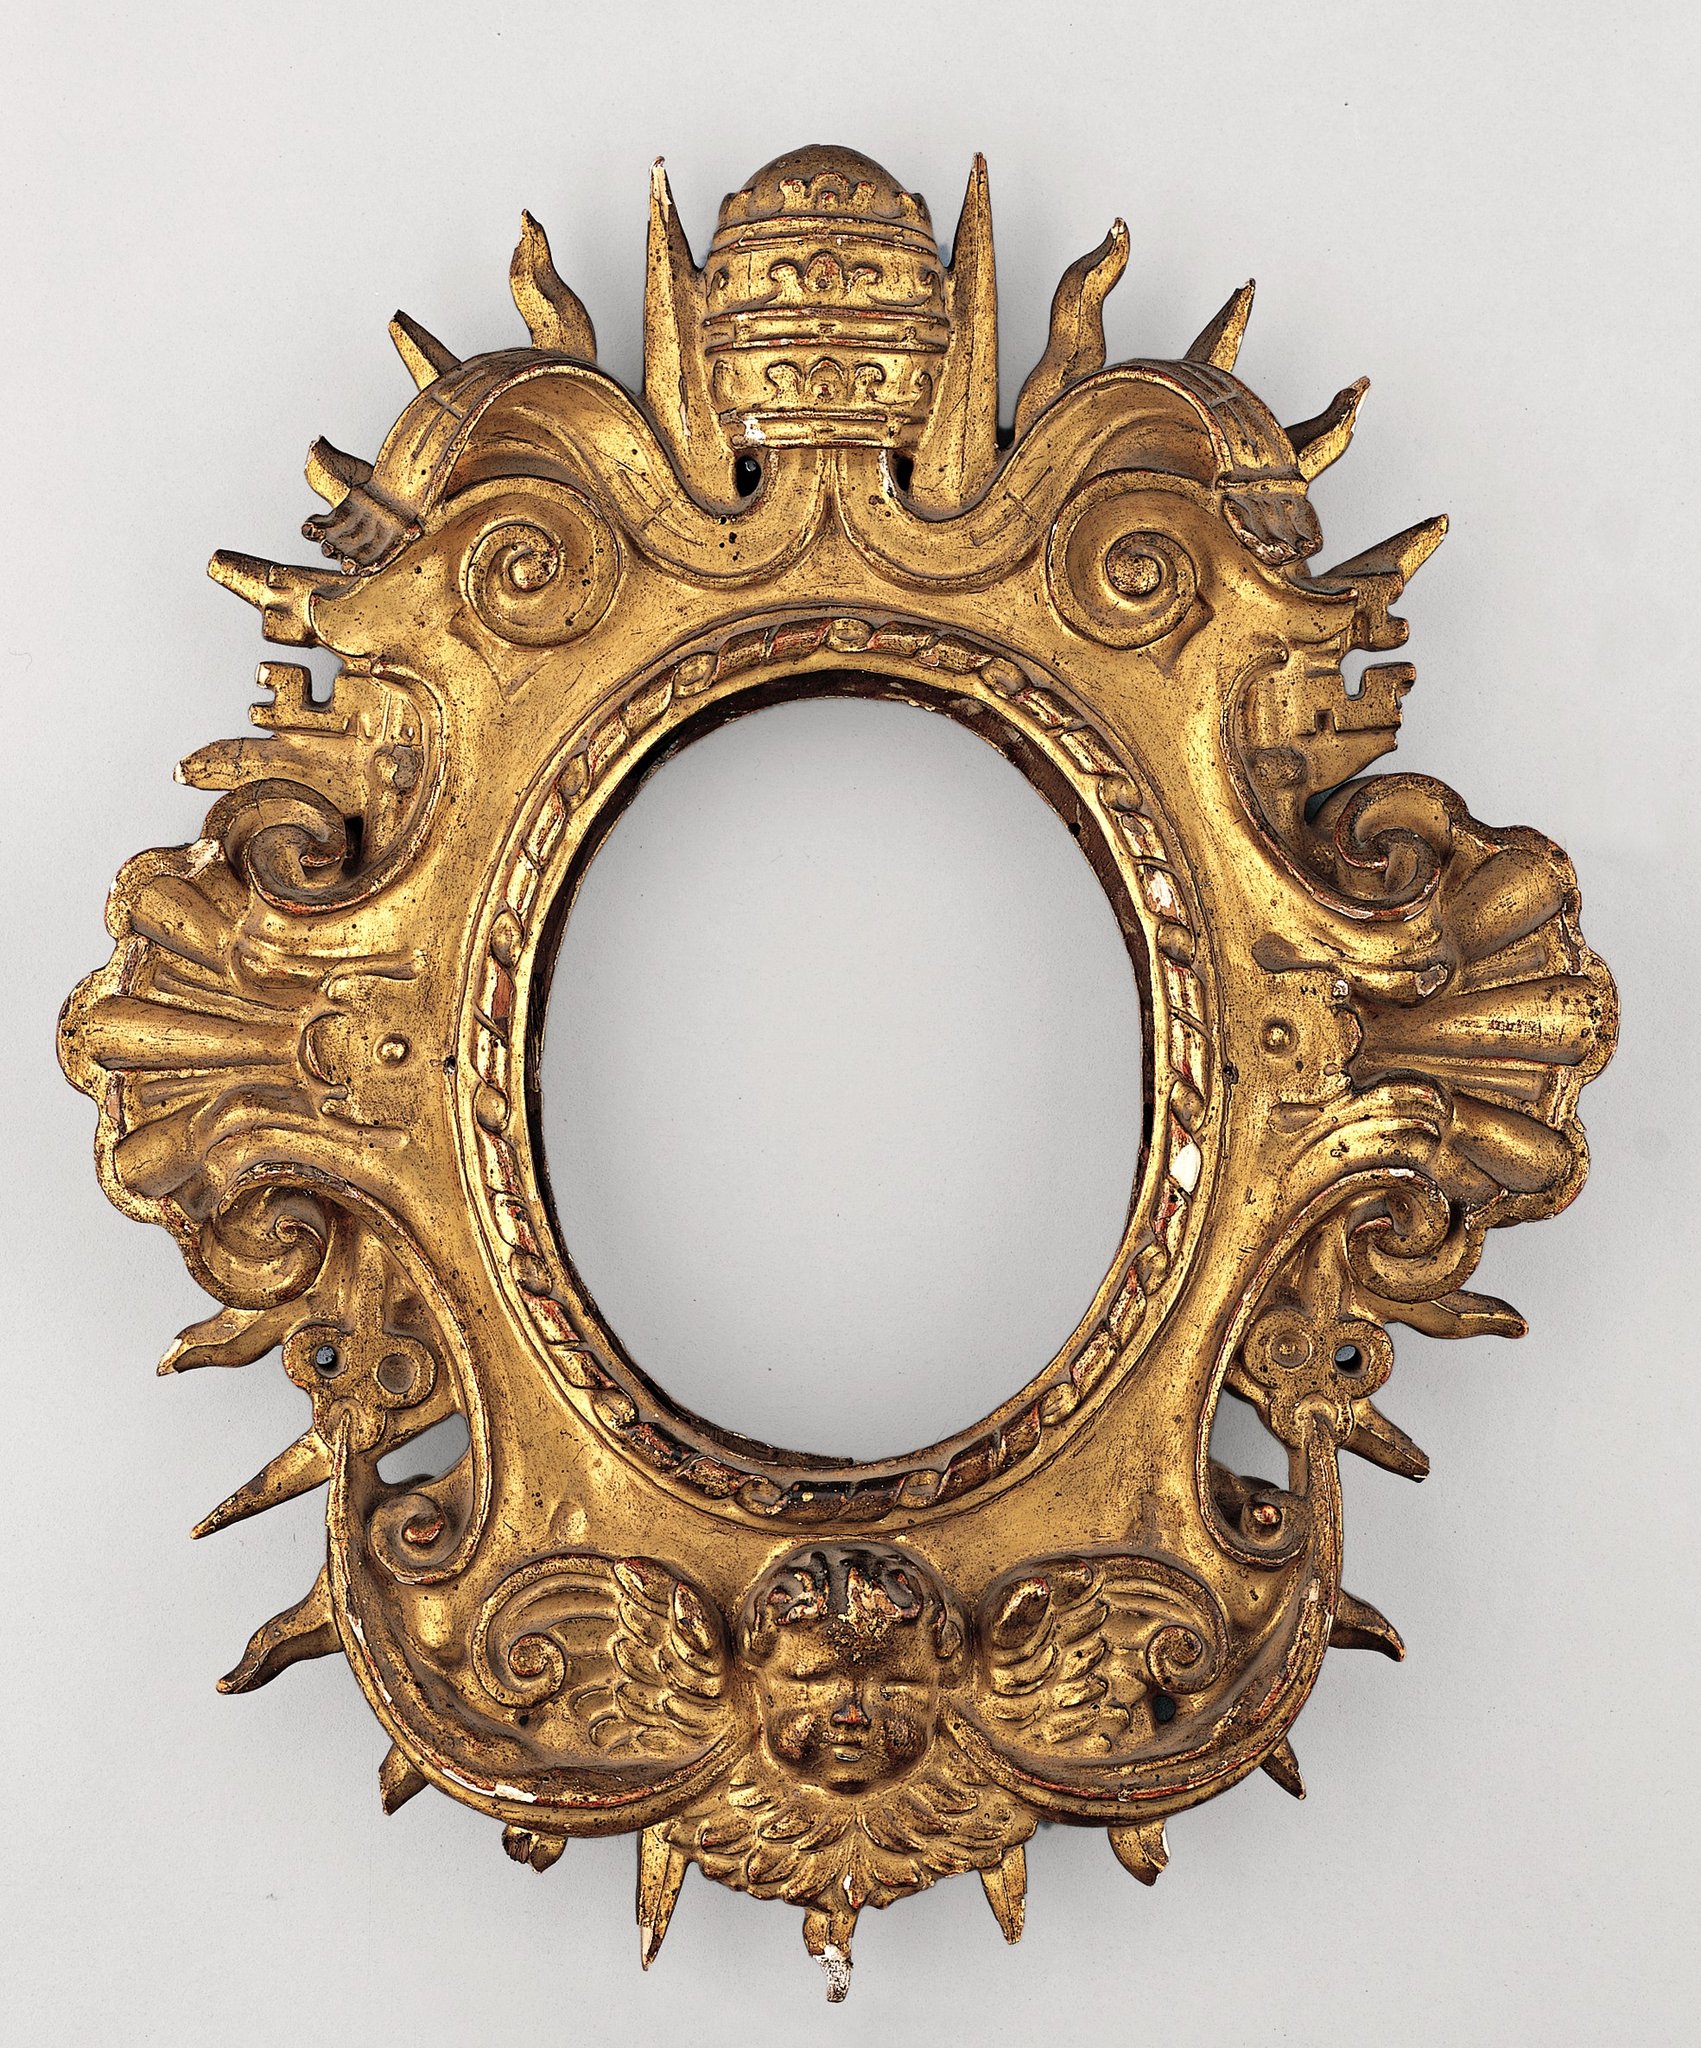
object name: frame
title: Monstrance or Agnus Dei frame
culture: italian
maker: Anonymous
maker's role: artist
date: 1834-1866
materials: wood